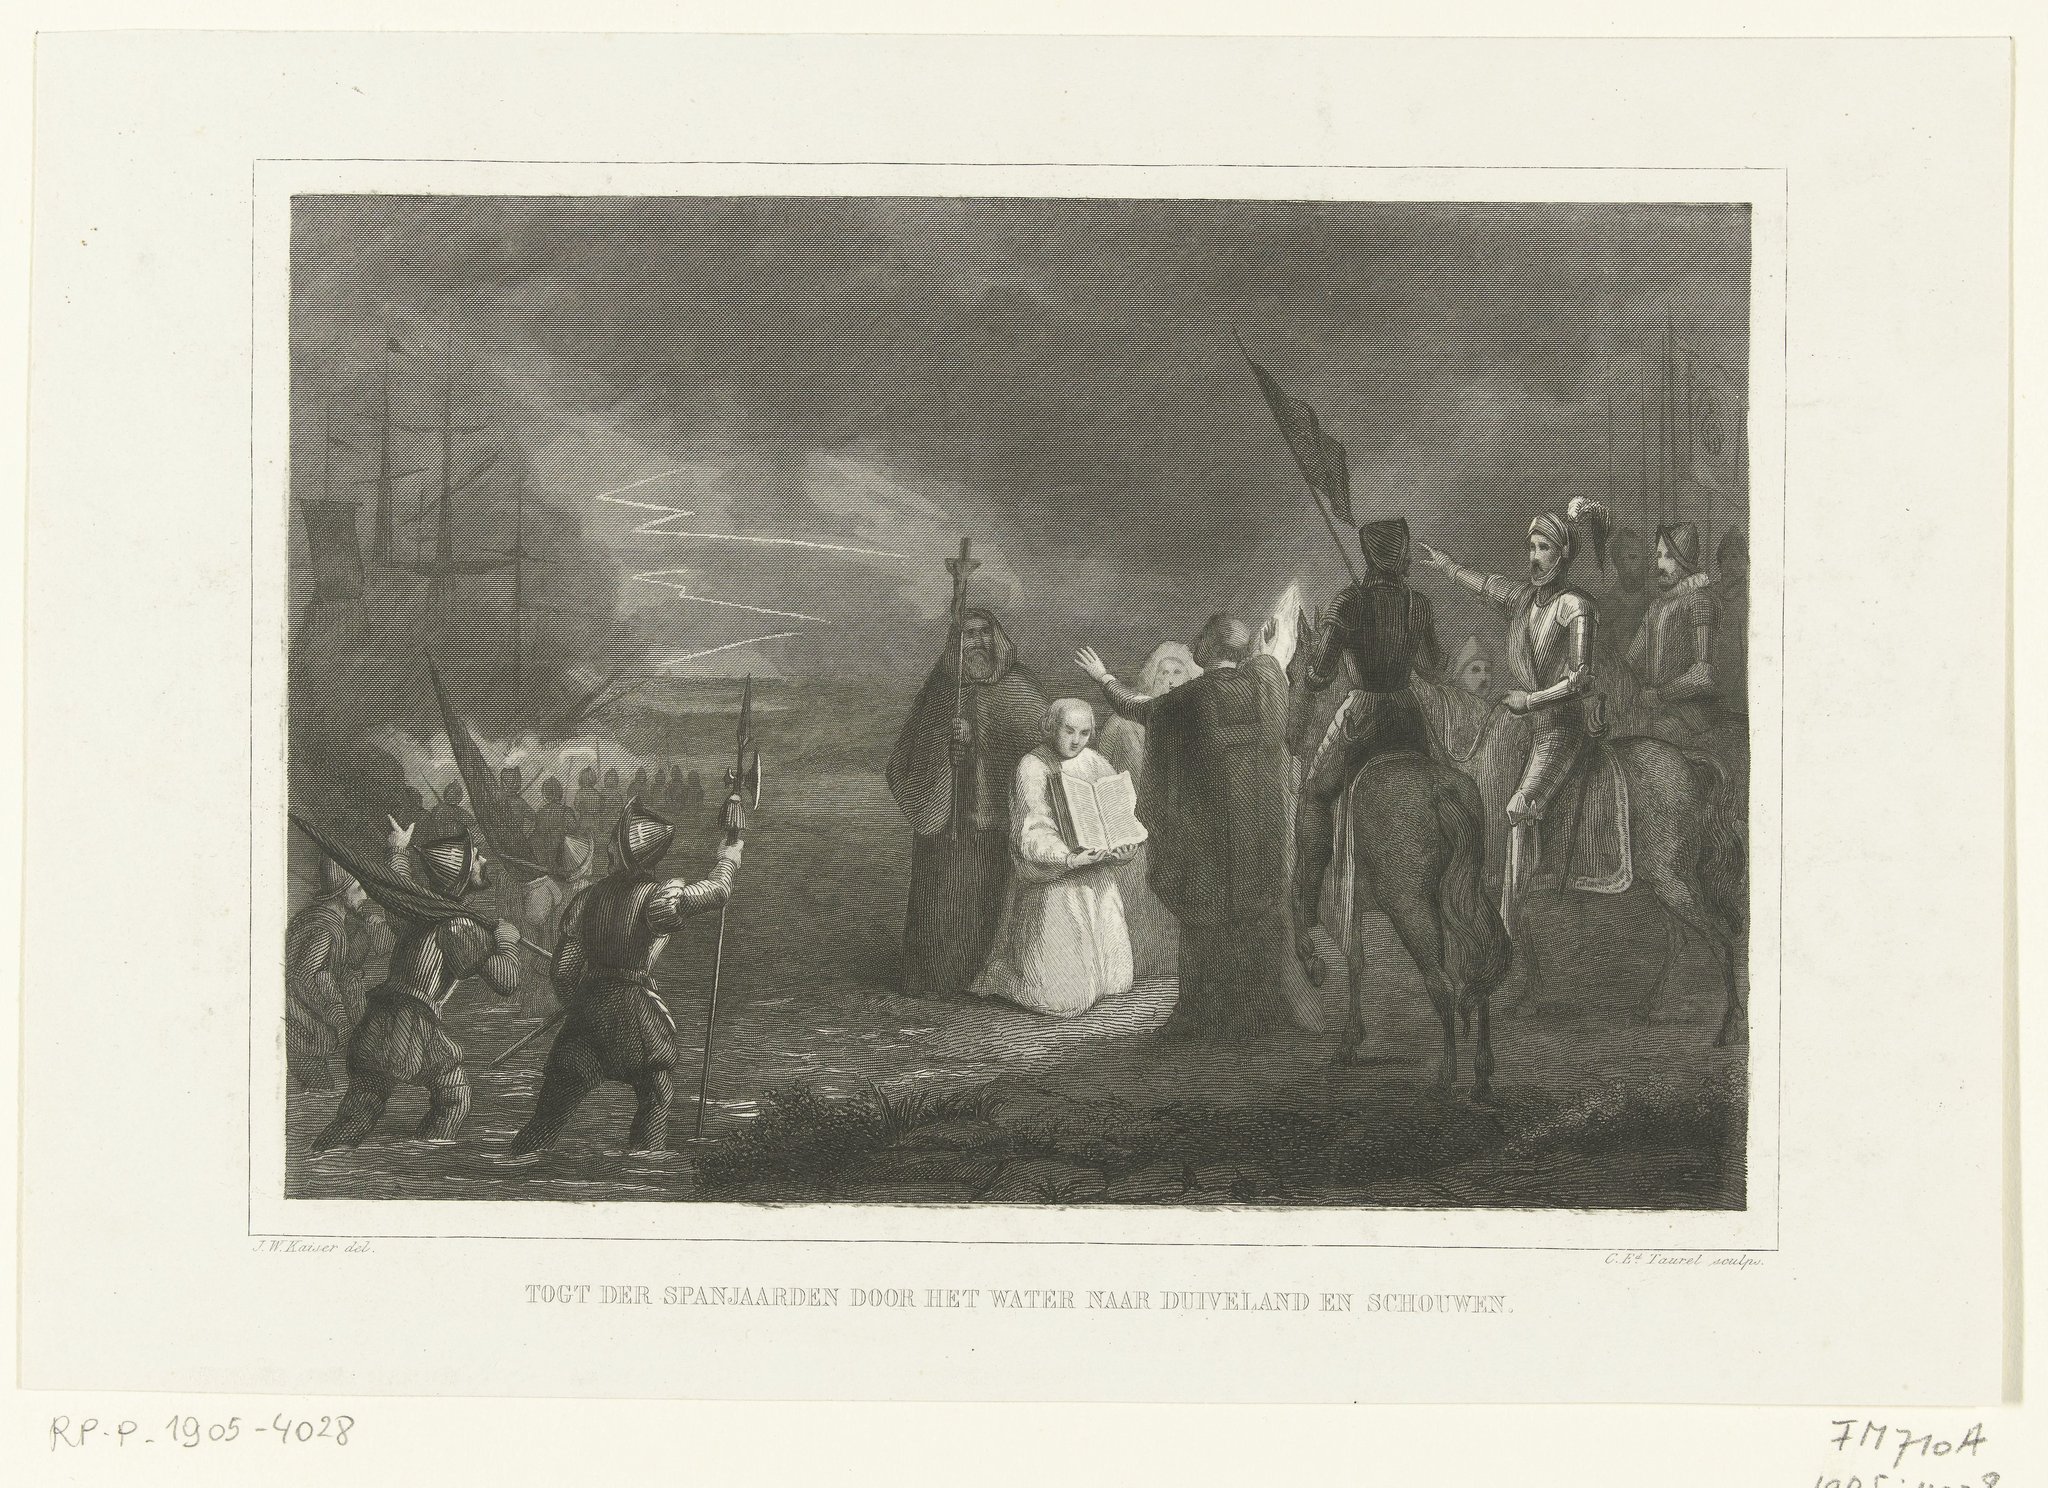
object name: print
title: Nachtelijk tocht van Spaanse soldaten door het water naar Duiveland, 1575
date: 1849-1851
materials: paper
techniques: engraving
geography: netherlands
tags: brussels, luis de zúñiga y requesens, army 'en route'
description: Nachtelijk tocht van Spaanse soldaten van Sint-Philipsland door het water naar het eiland Duiveland, 28 september 1575. Op de voorgrond op Tholen zegent een jezuïet bij een opengeslagen bijbel de vertrekkende soldaten, boven het water bliksem. Rechts veldheren in harnas te paard.